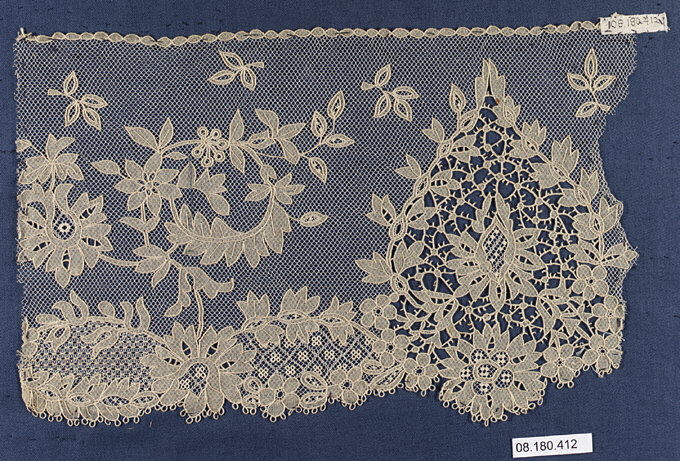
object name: fragment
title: Fragment of Carrickmacross lace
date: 1801-1900